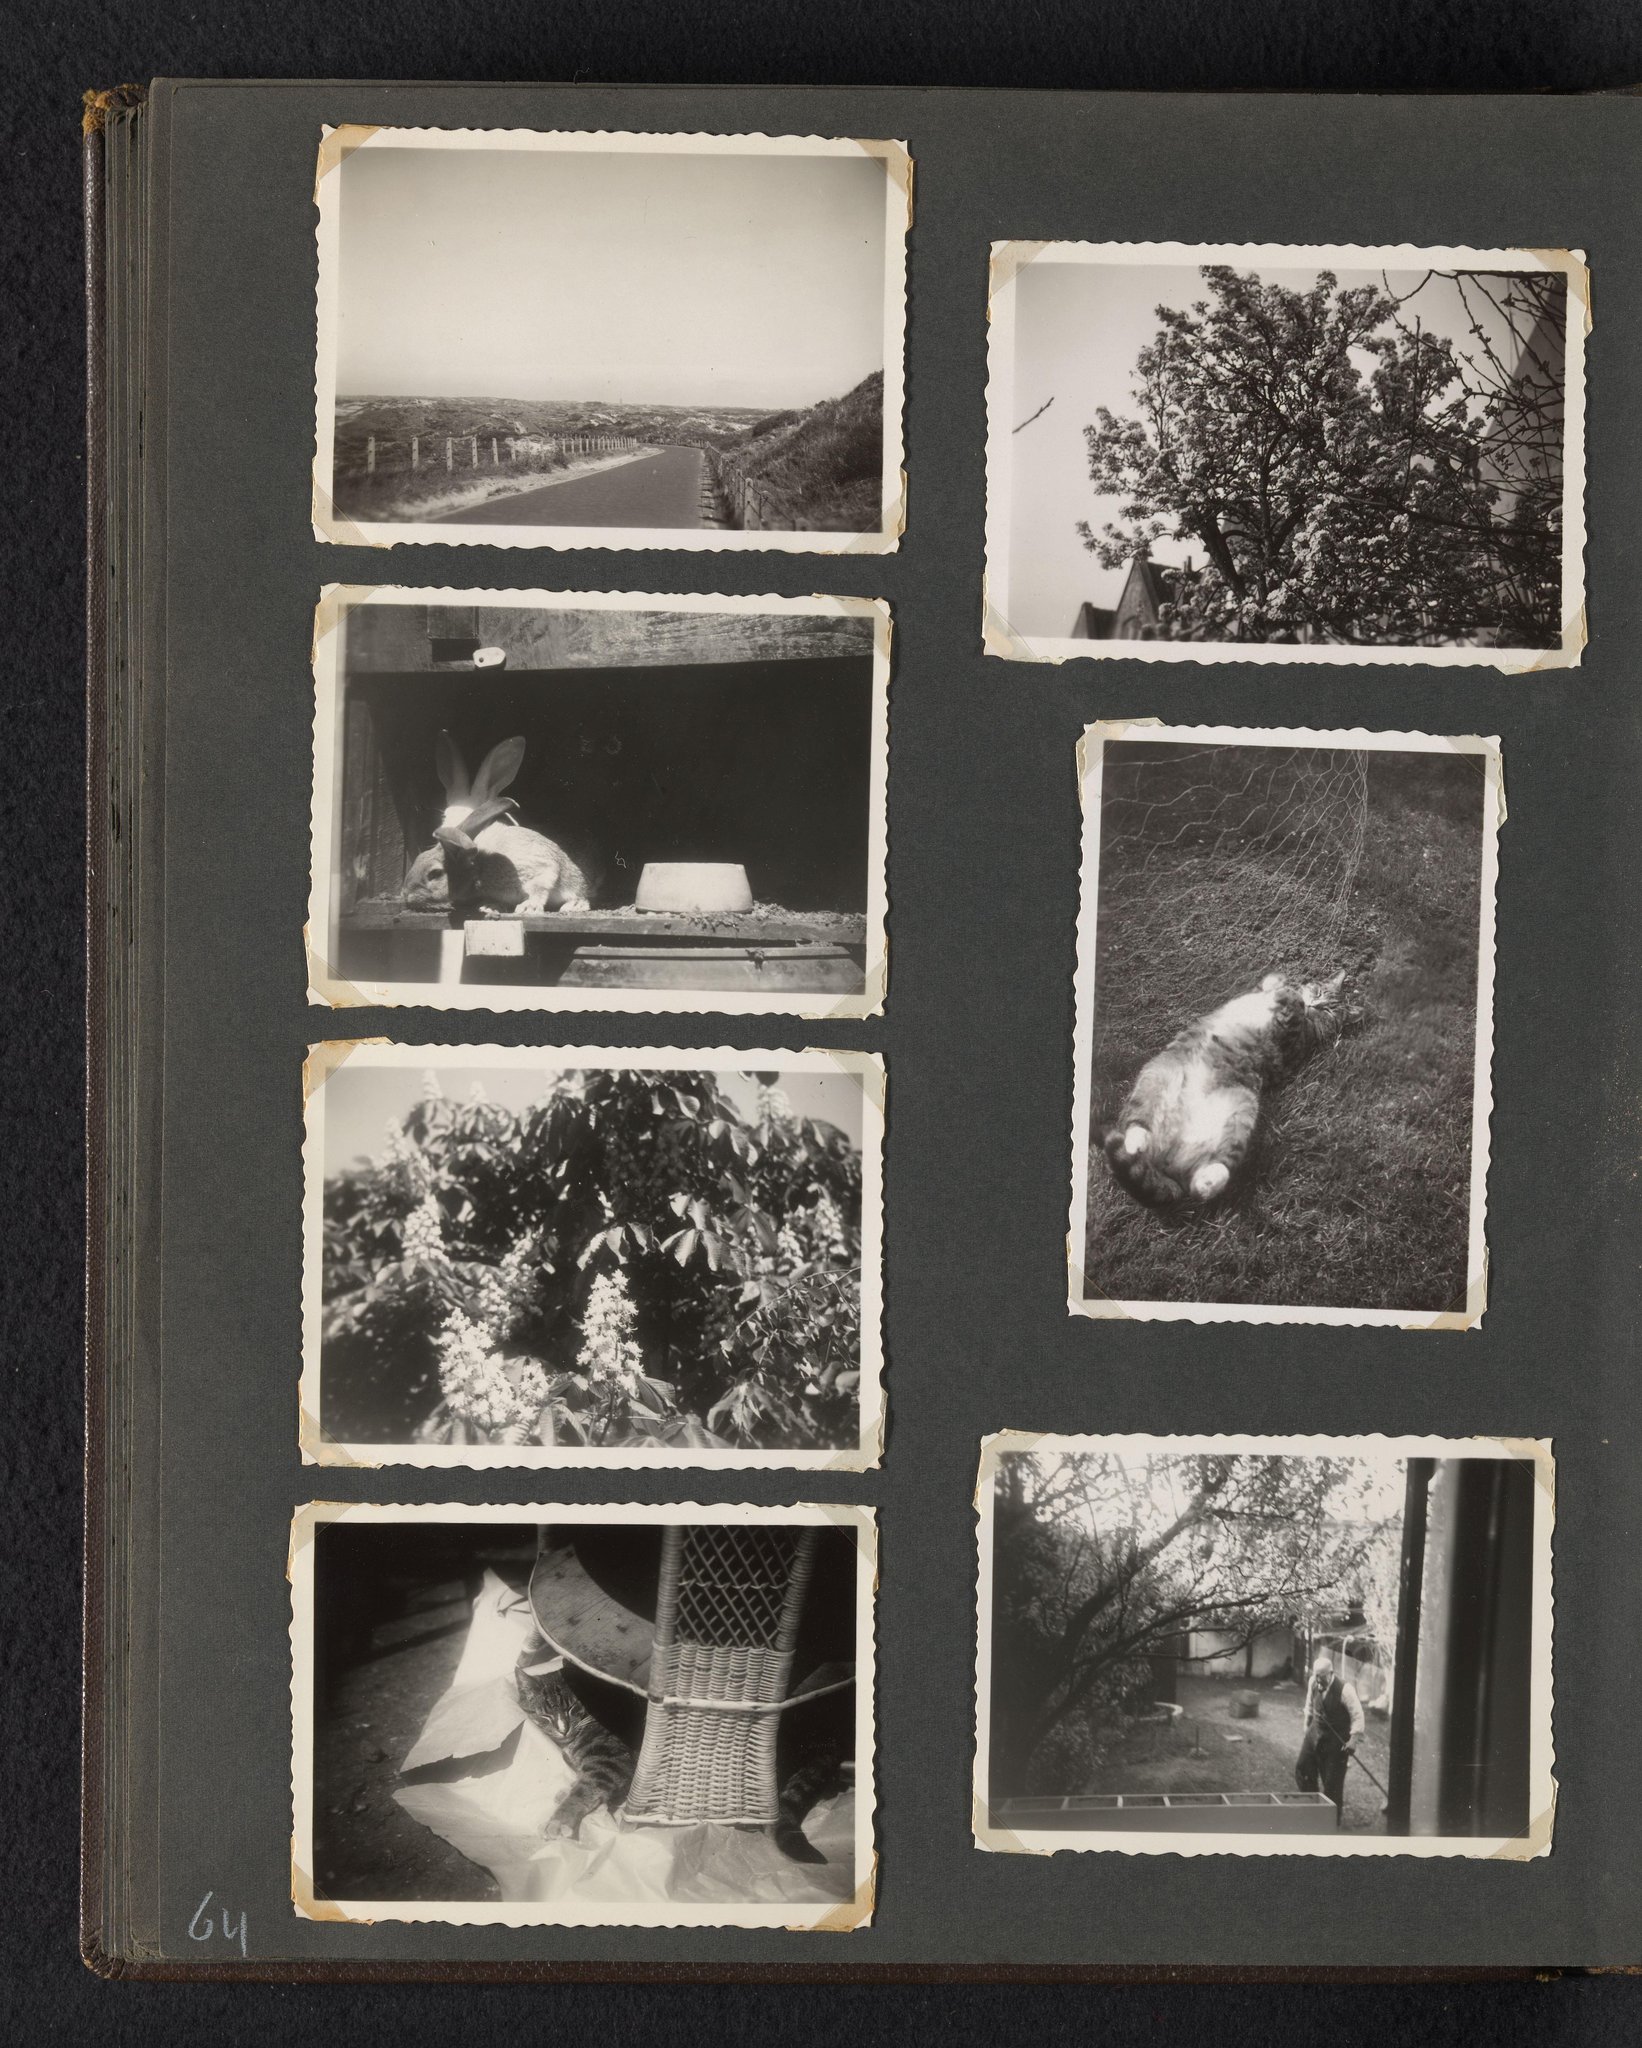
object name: album leaf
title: In en om het huis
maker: Anonymous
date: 1950-1951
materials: cardboard, photographic support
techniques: gelatin silver print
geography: netherlands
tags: cat, family life at home, rodents: rabbit, netherlands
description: Albumblad met zeven foto's in en om het huis, huisdieren en een weg door de duinen. Onderdeel van het fotoalbum 'Mijn jaren in Indië' met foto's over de militaire acties in Nederlands-Indië.